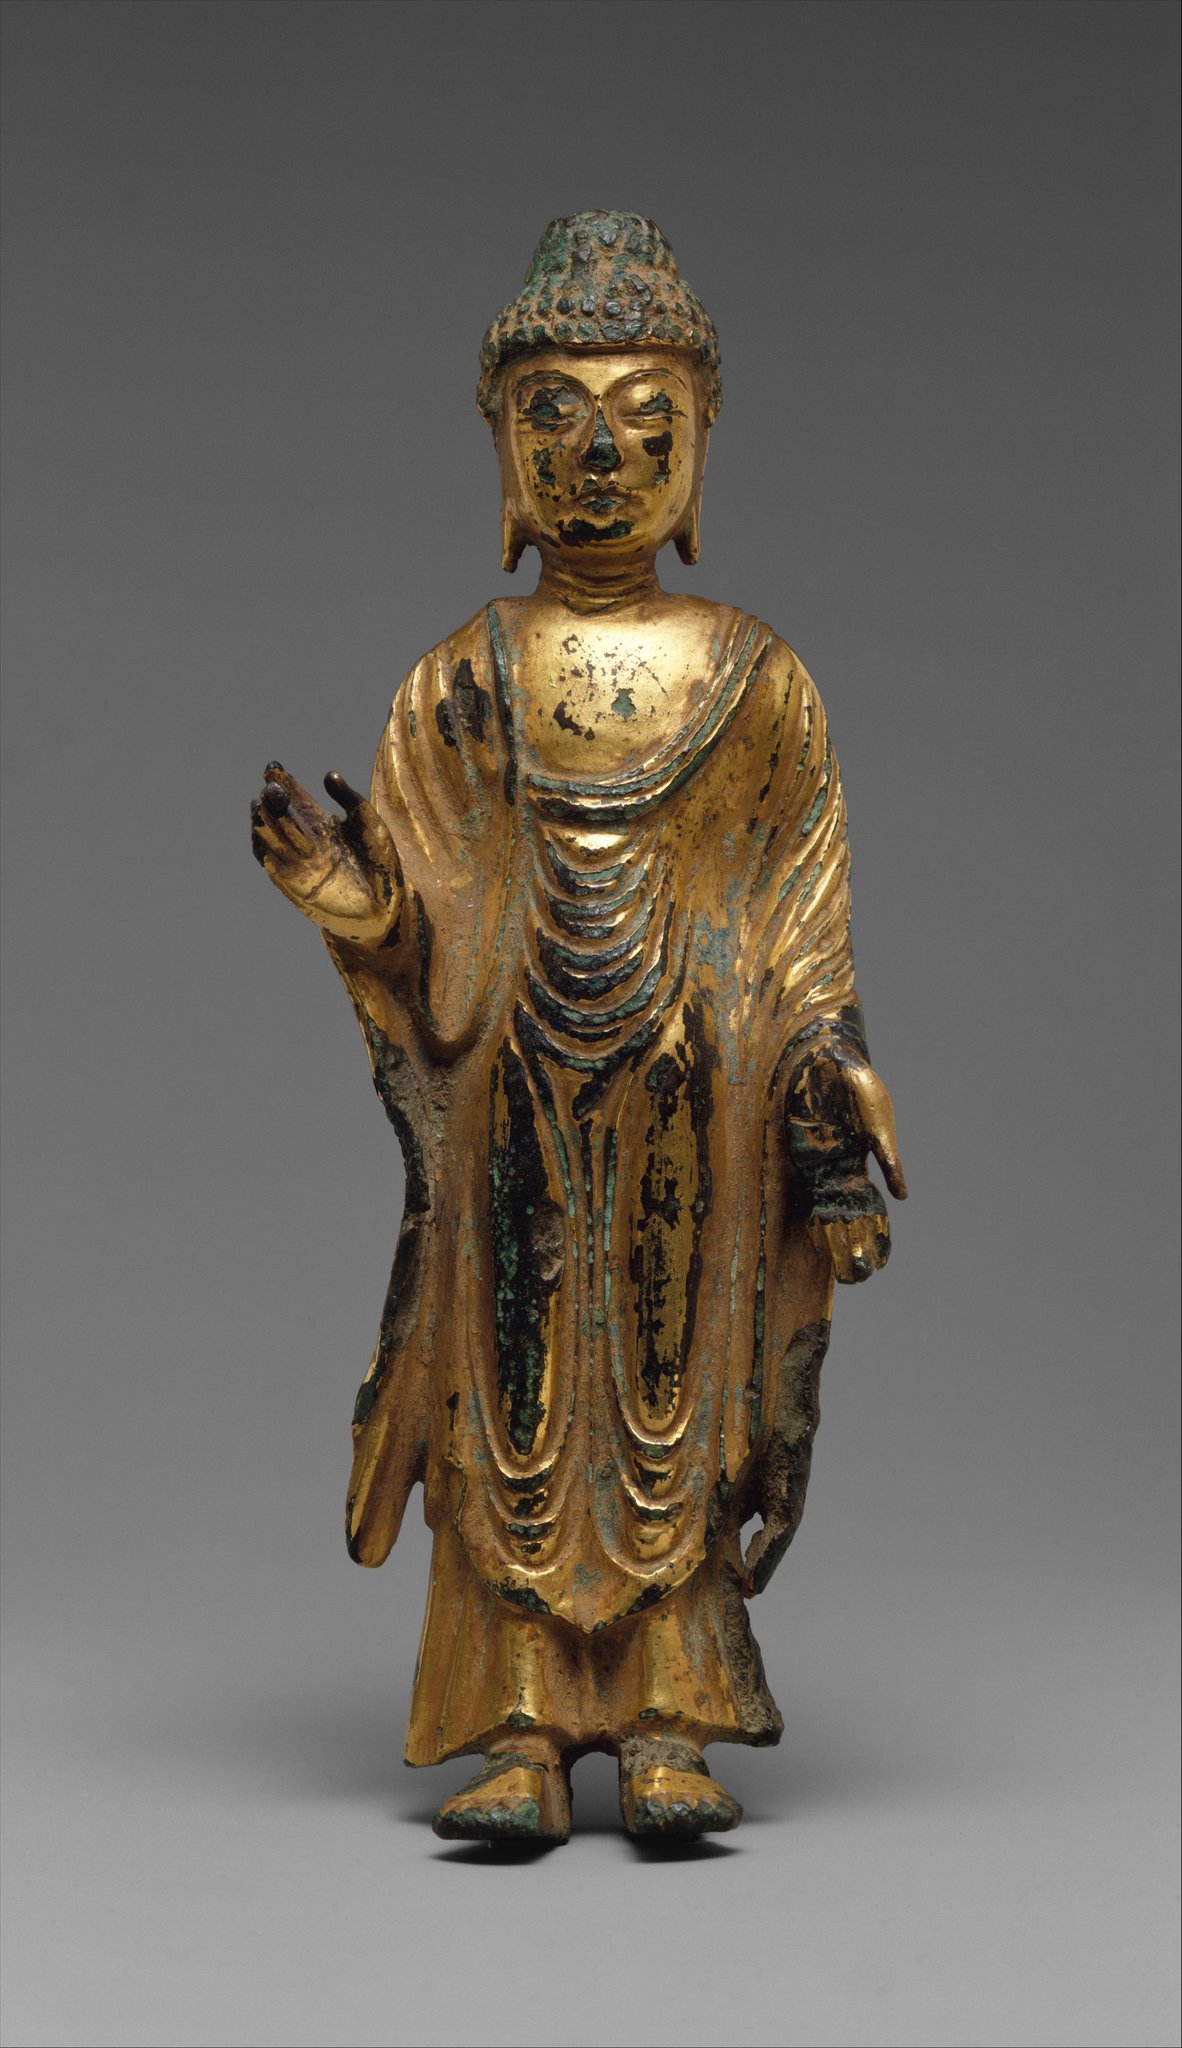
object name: statuette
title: Standing Buddha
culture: korean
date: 701-800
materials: gilt bronze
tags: buddhism,buddha